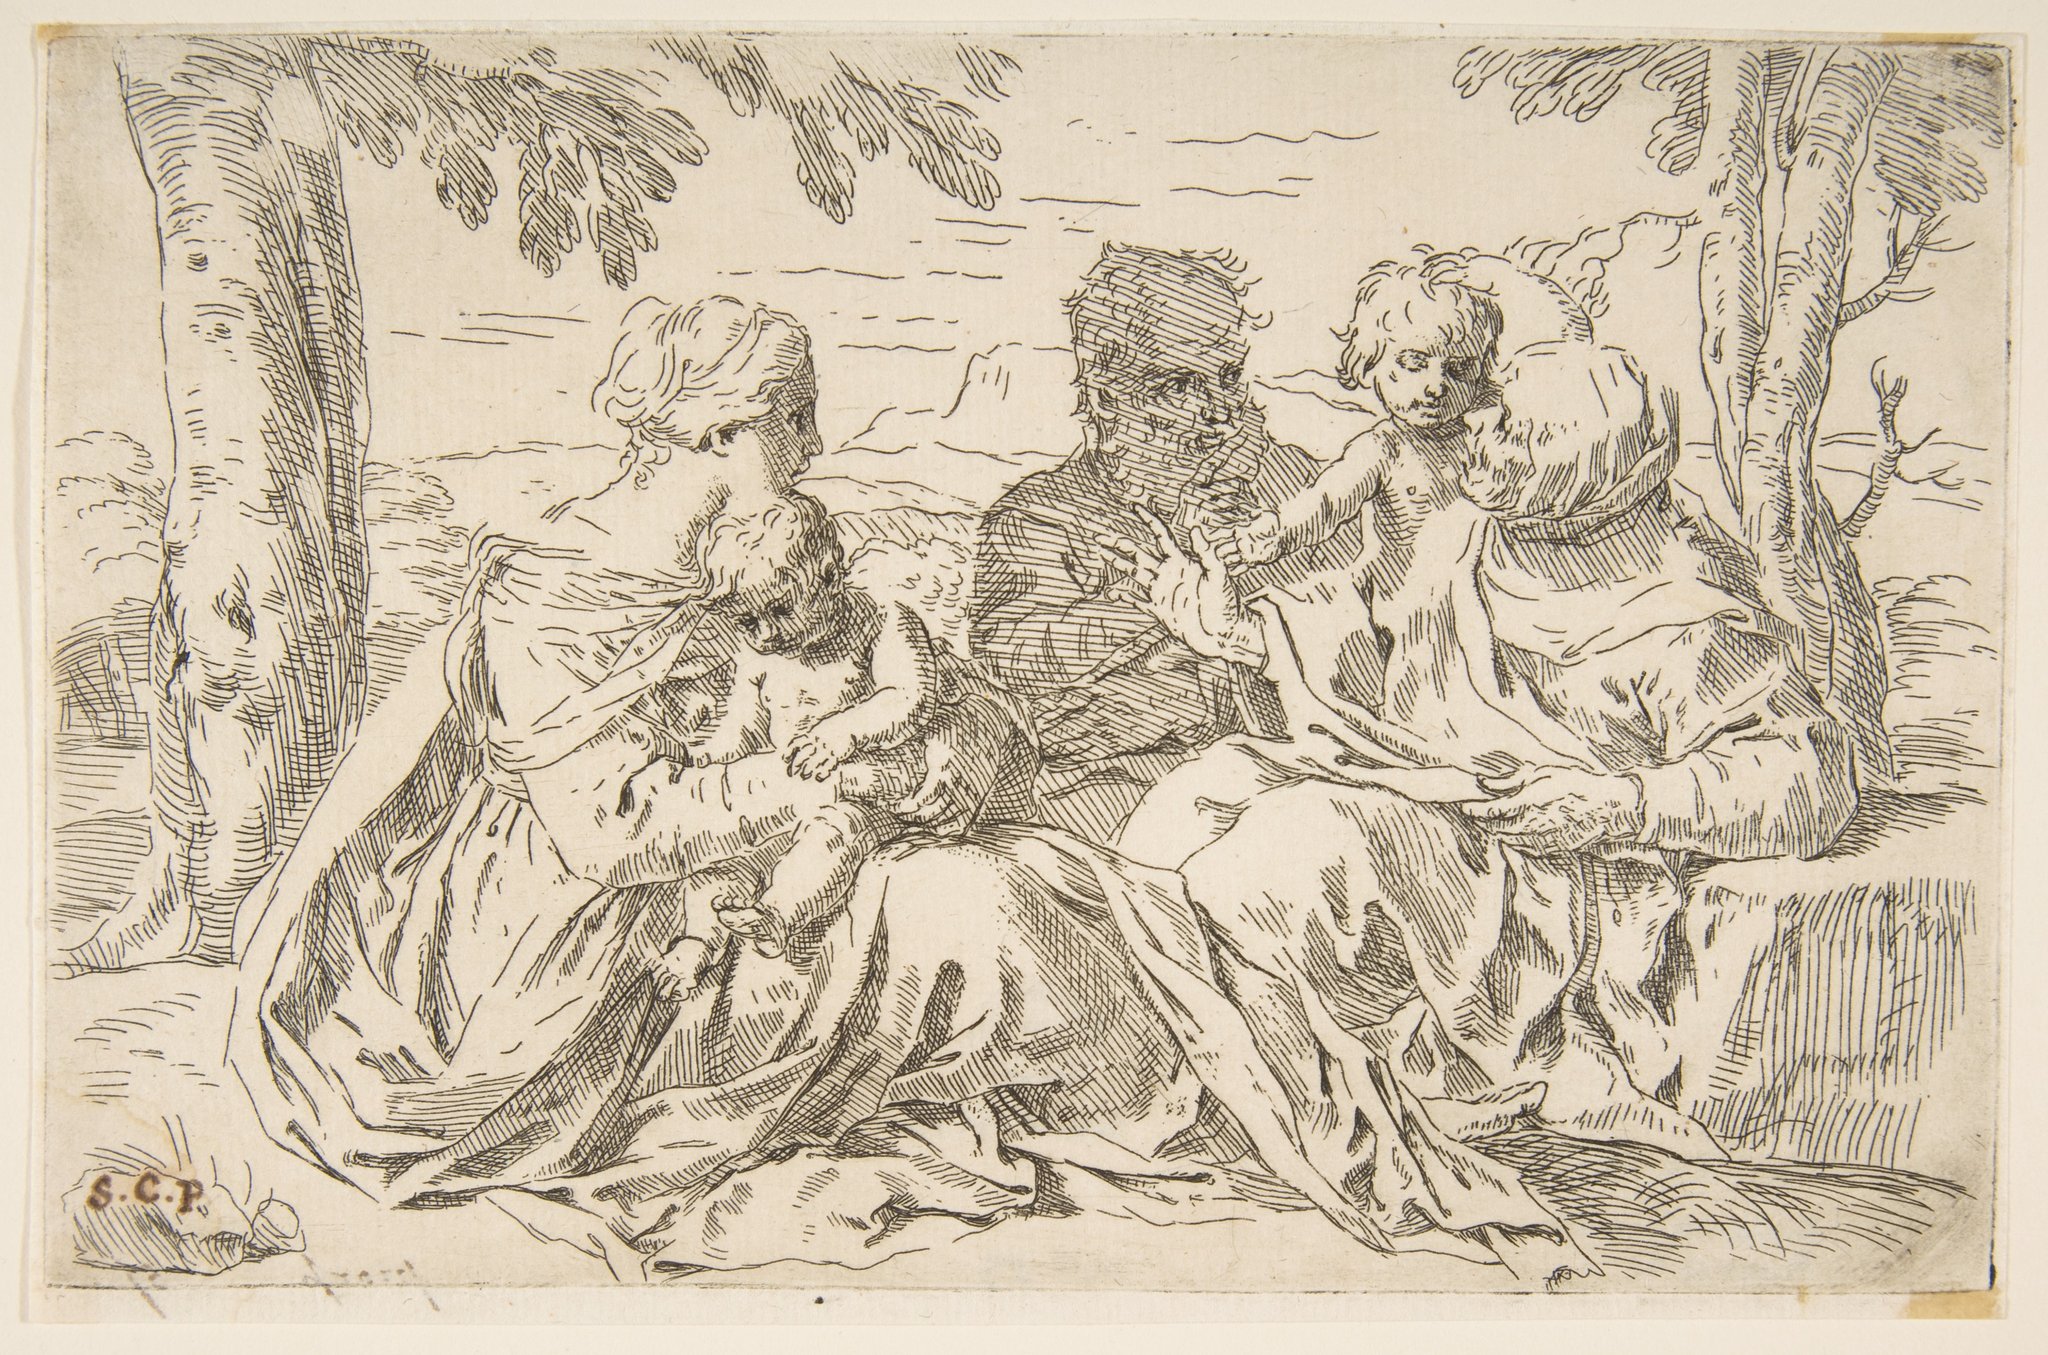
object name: print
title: Holy Family with Saint Elizabeth and Saint John the Baptist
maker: simone cantarini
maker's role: artist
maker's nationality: italian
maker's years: 1612-1648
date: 1639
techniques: etching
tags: women,holy family,saint john the baptist